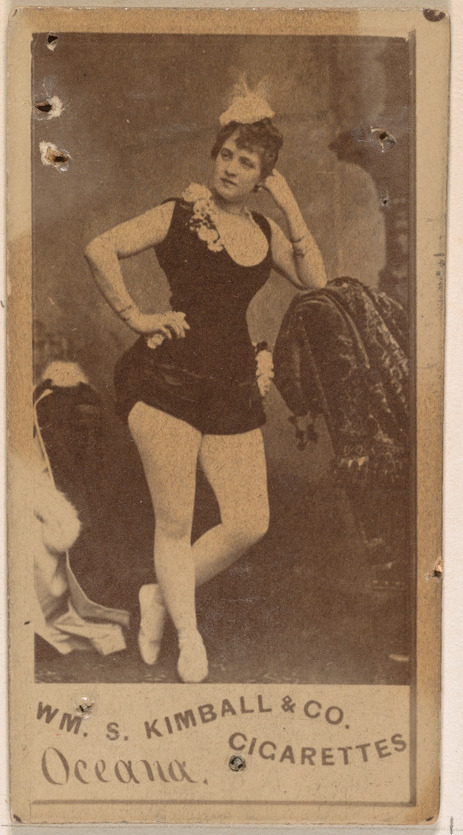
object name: photograph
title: Miss Oceana, from the Actresses series (N203) issued by Wm. S. Kimball & Co.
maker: william s. kimball & company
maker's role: publisher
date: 1889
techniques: color lithograph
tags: portraits,women,actresses